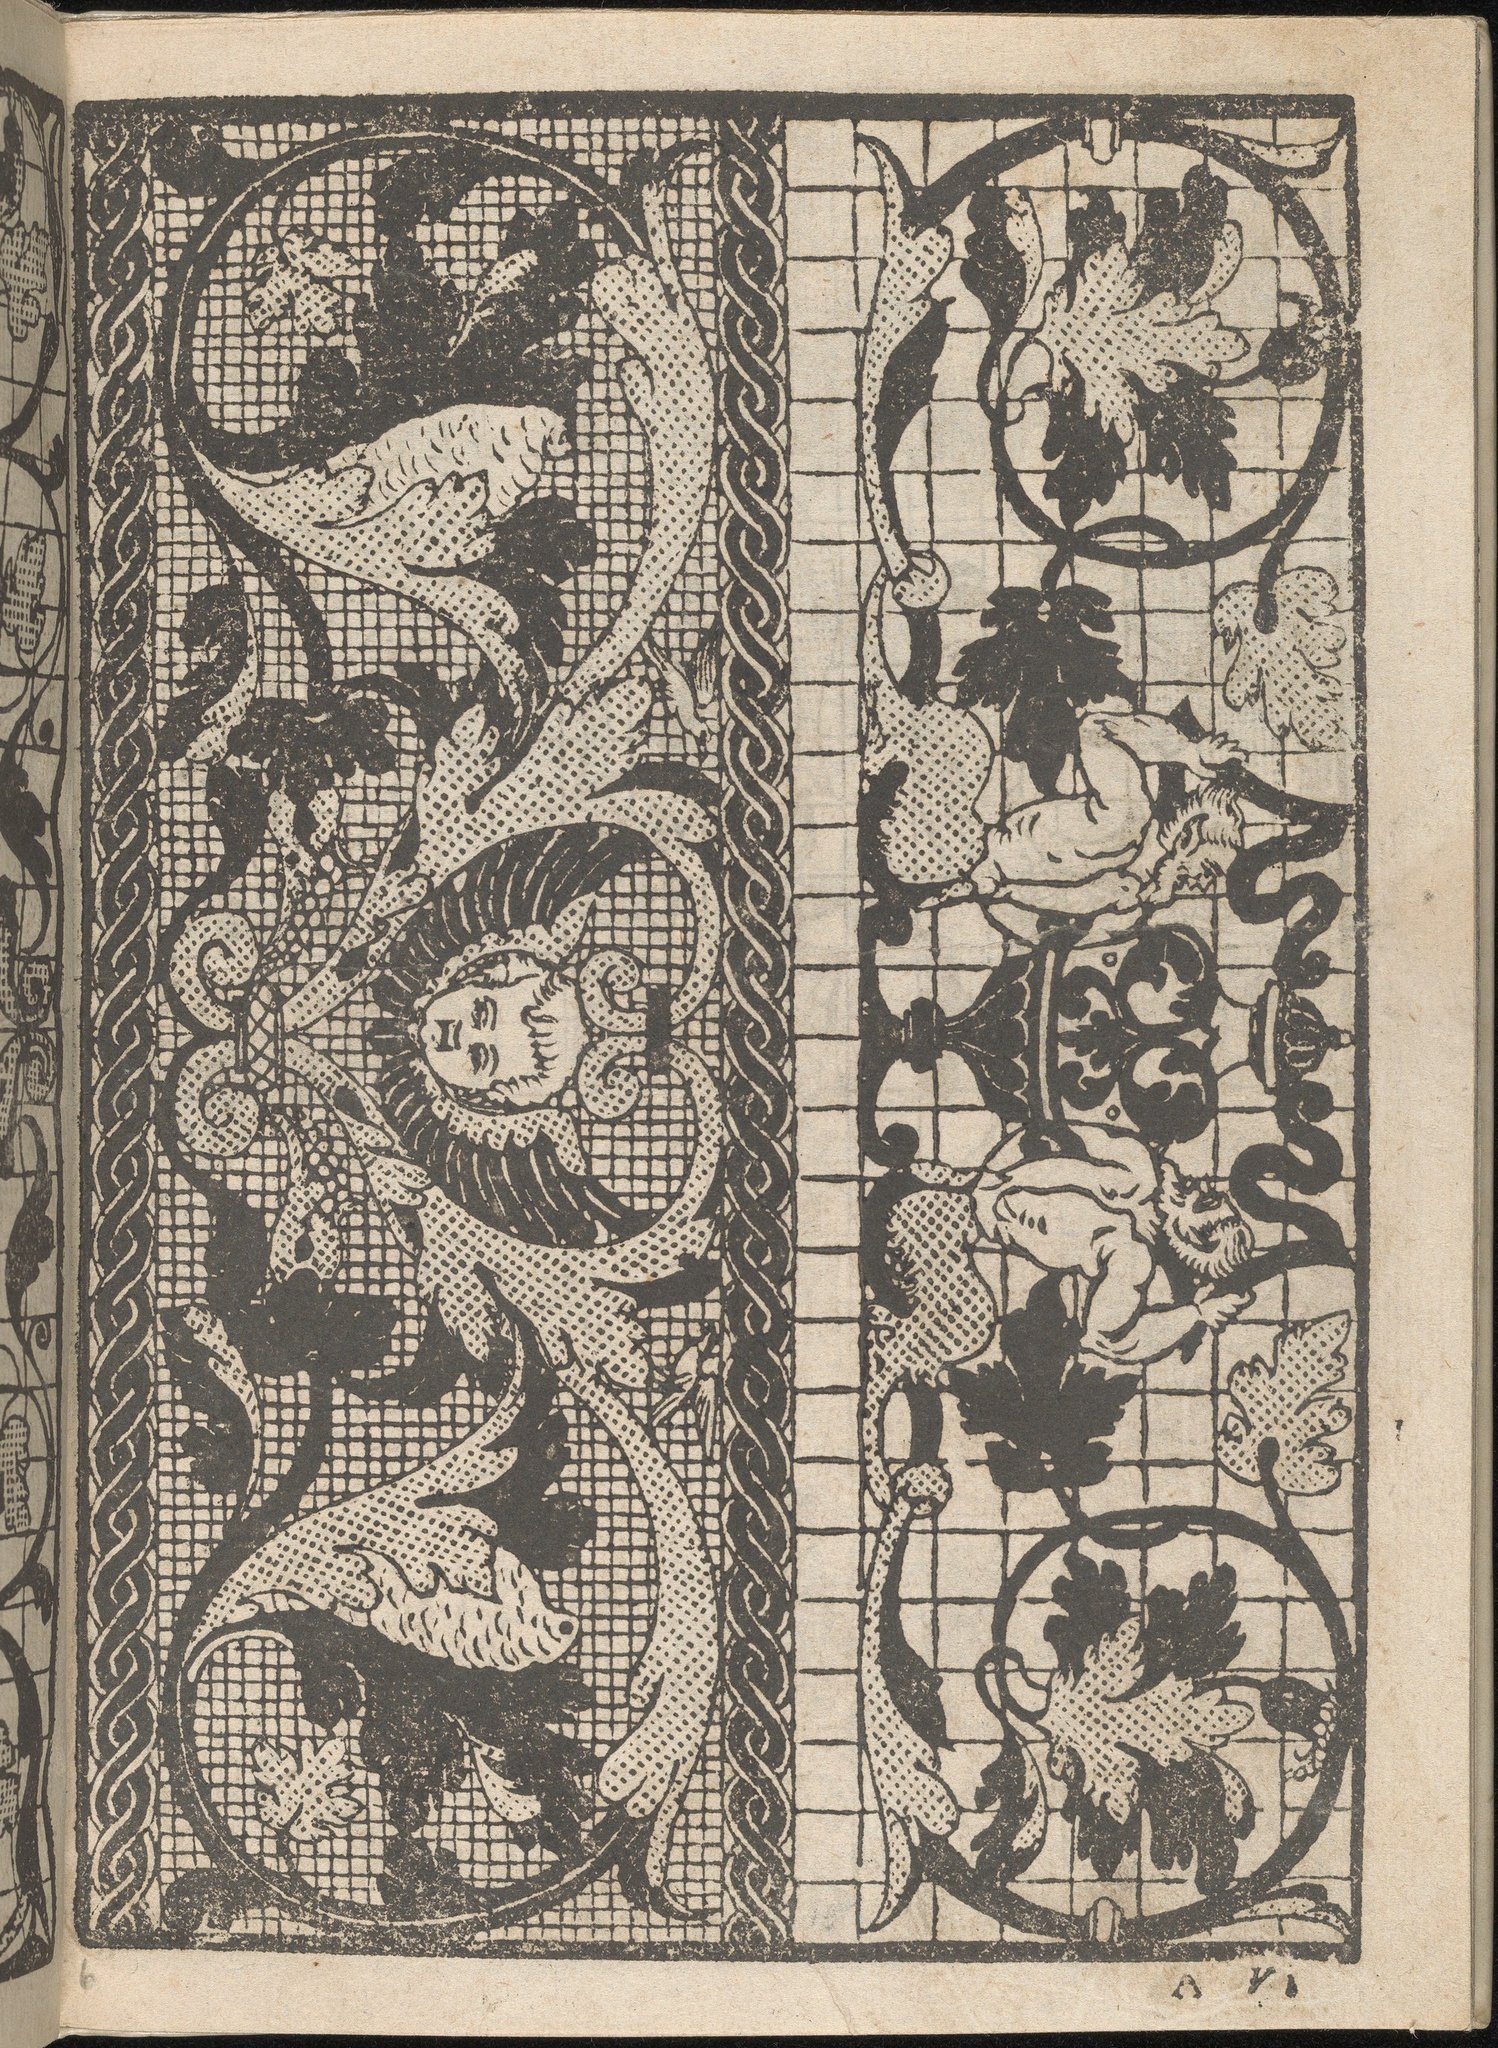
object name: book print ornament architecture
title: Splendore delle virtuose giovani, page 3 (verso)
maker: iseppo foresto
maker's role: designer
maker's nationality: italian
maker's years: 1520-1580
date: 1564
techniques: woodcut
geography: italy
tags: peacocks,flowers,vines